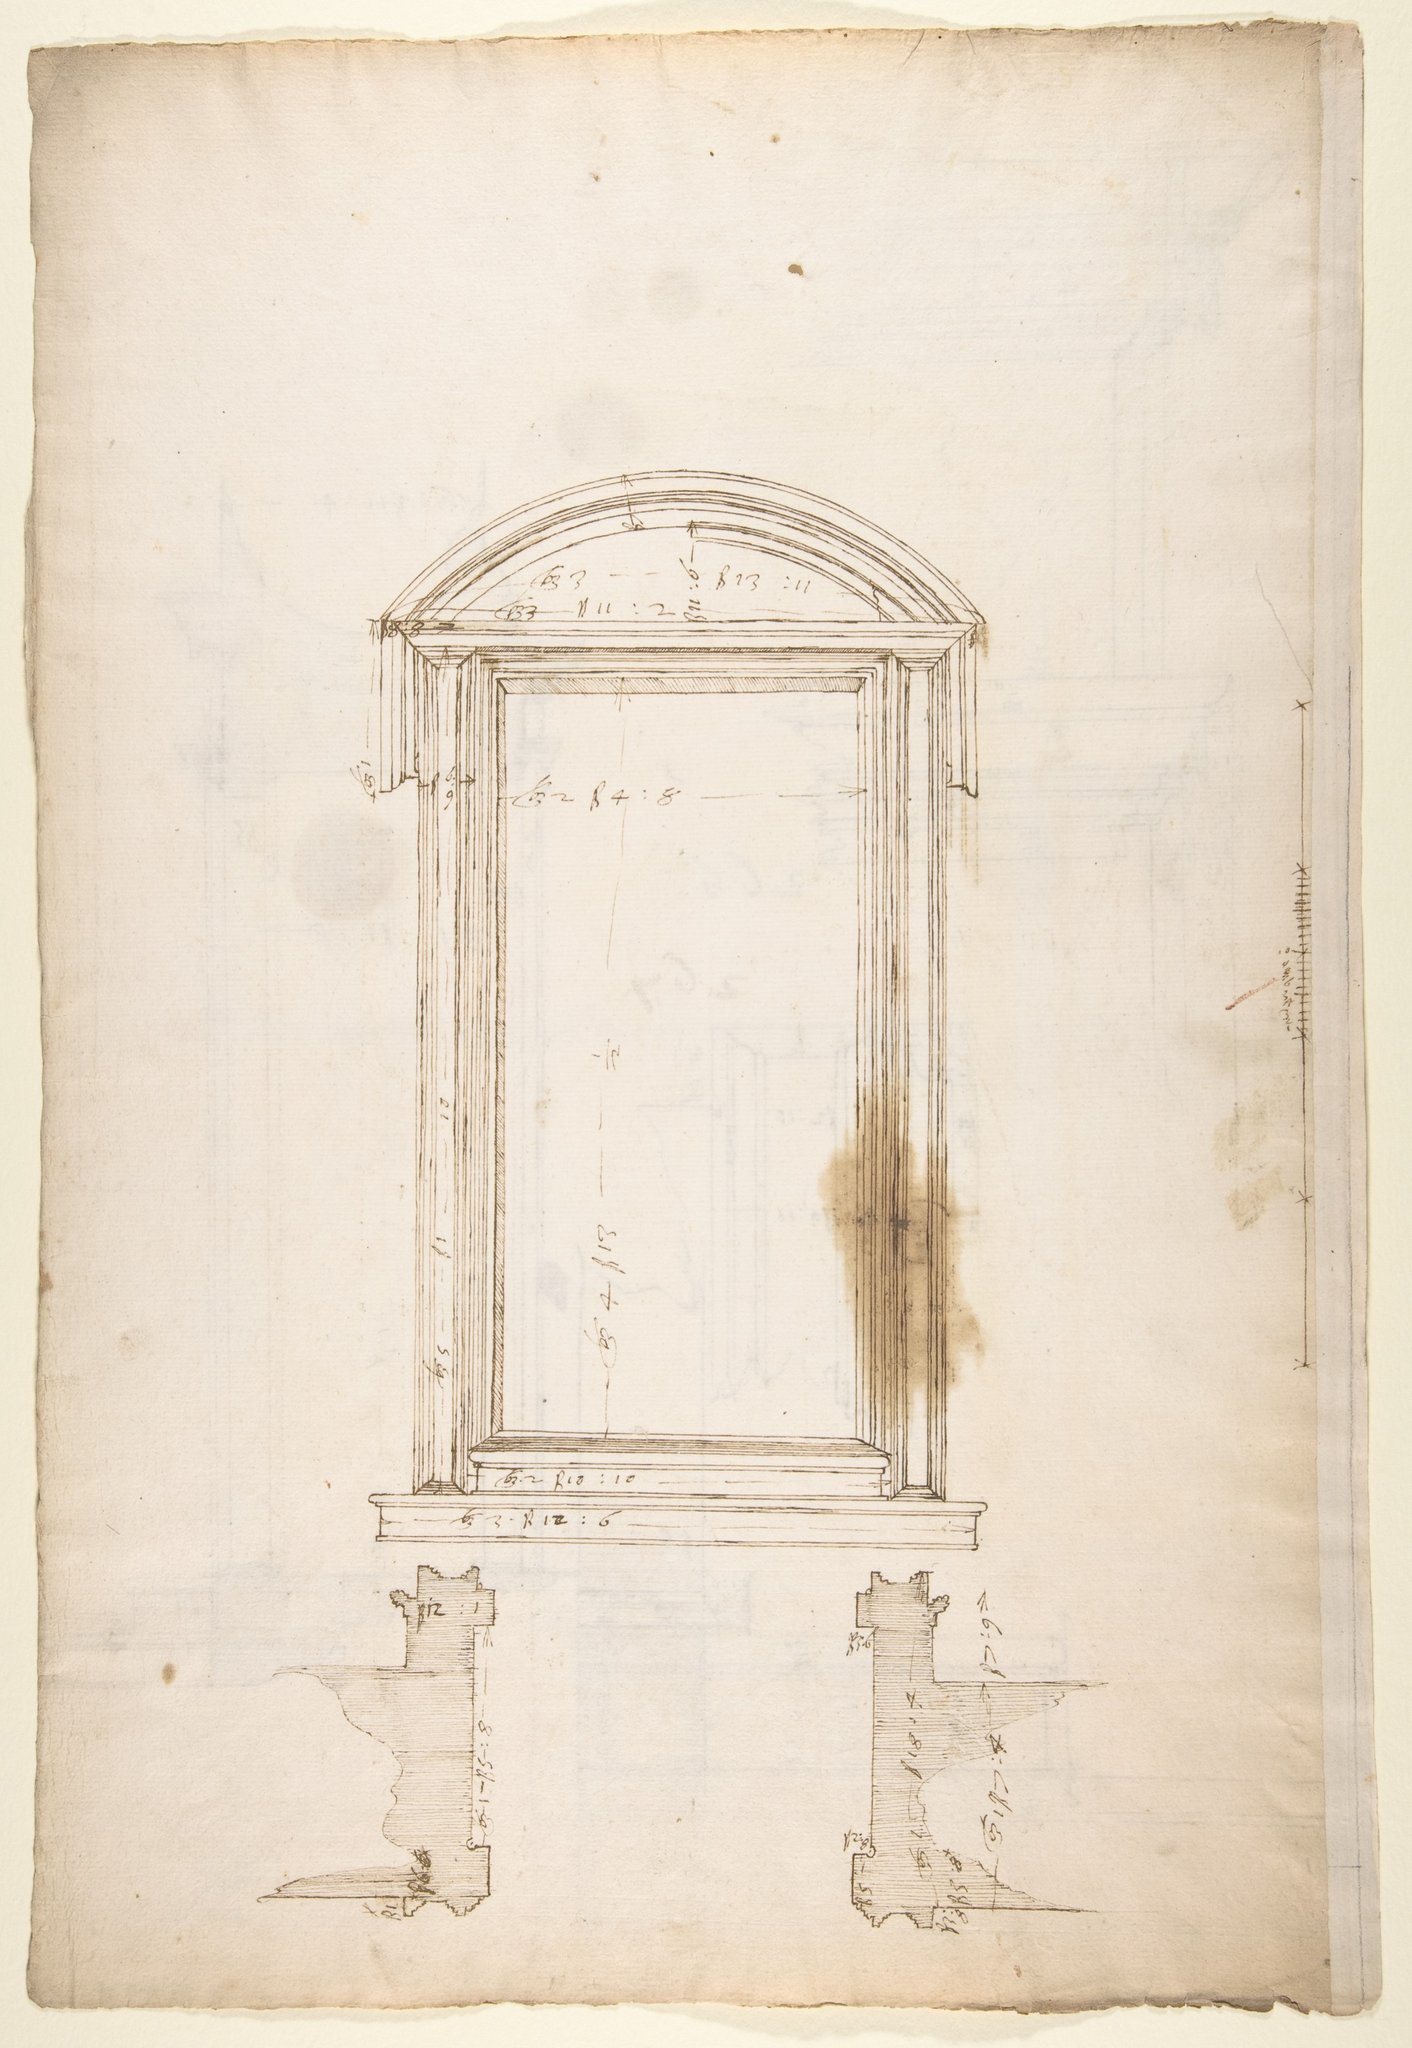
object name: drawing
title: San Lorenzo, Library, Ricetto, portal to Ricetto, elevation; plan (recto) San Lorenzo, Library, Ricetto, portal to Ricetto, section; details (verso)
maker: anonymous, french, 16th century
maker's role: draftsman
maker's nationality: french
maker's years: 1500-1600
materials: chalk, ink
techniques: incising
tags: architecture